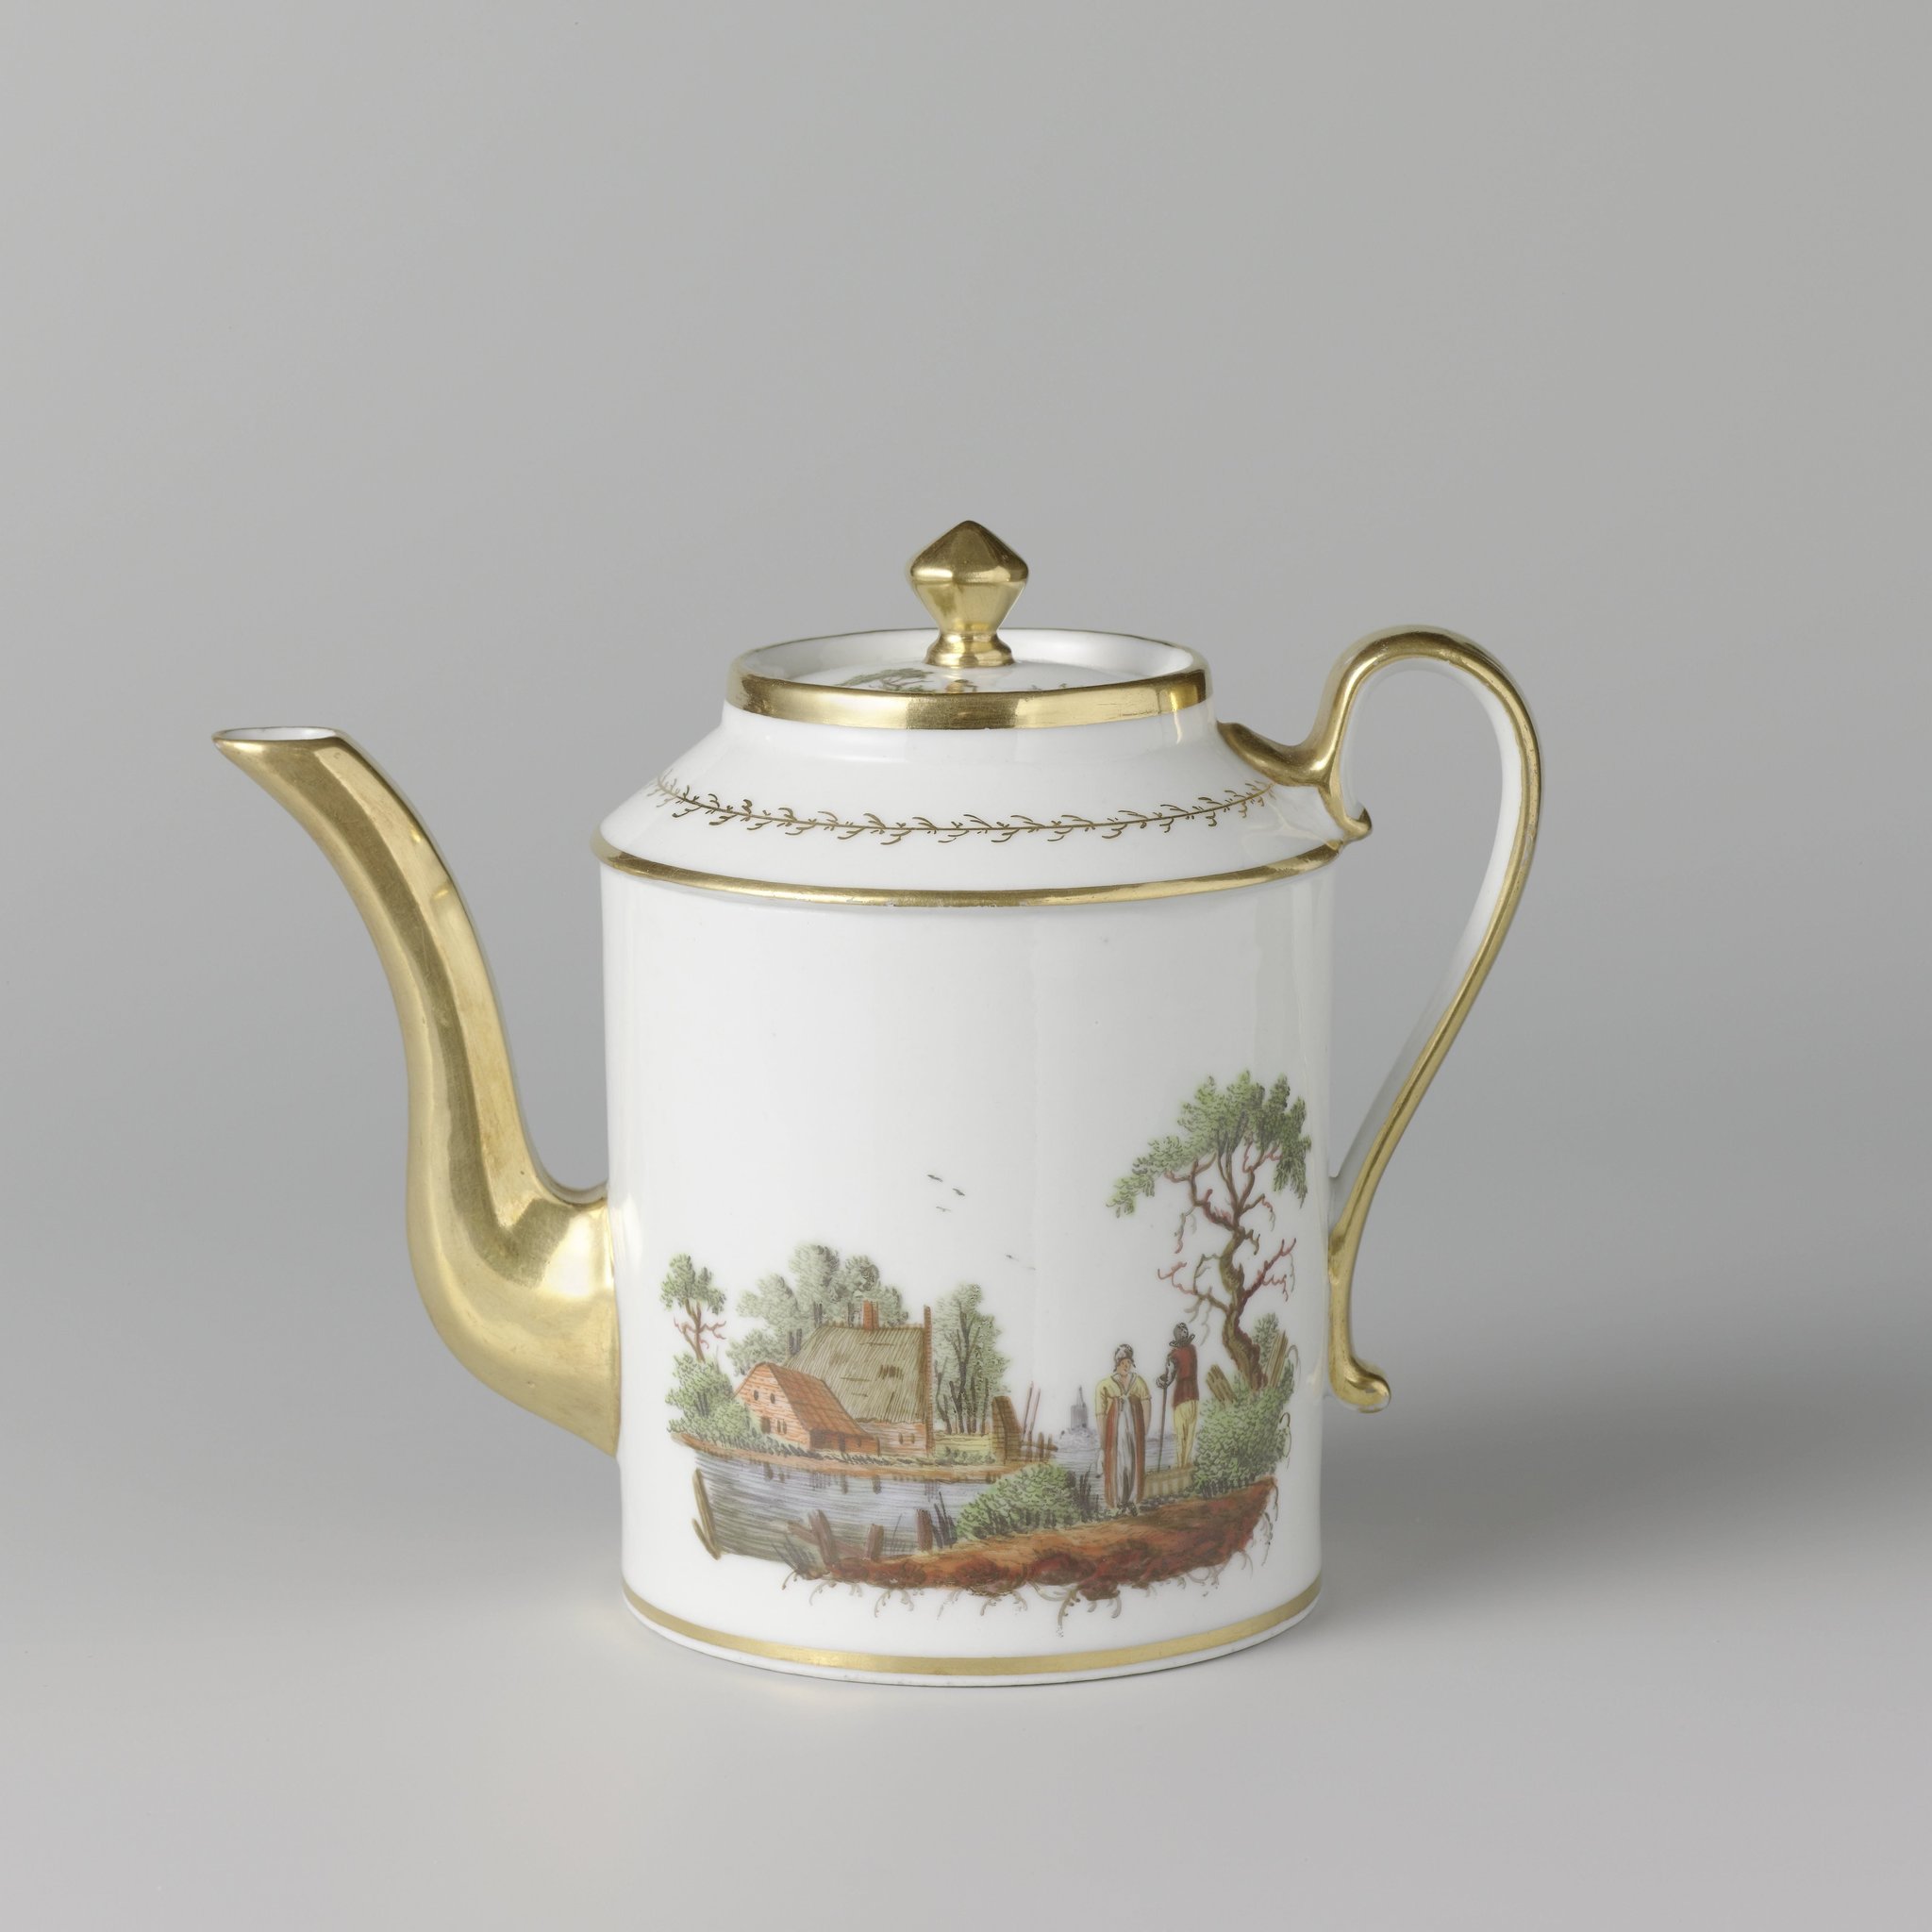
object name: teapot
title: Teapot and milk jug, part of a tea service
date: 1809-1814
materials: porcelain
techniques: painted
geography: nieuwer-amstel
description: Koninklijke Porseleinfabriek Dommer & Co. Nieuwer-Amstel, c. 1809–1814 hard-paste porcelain